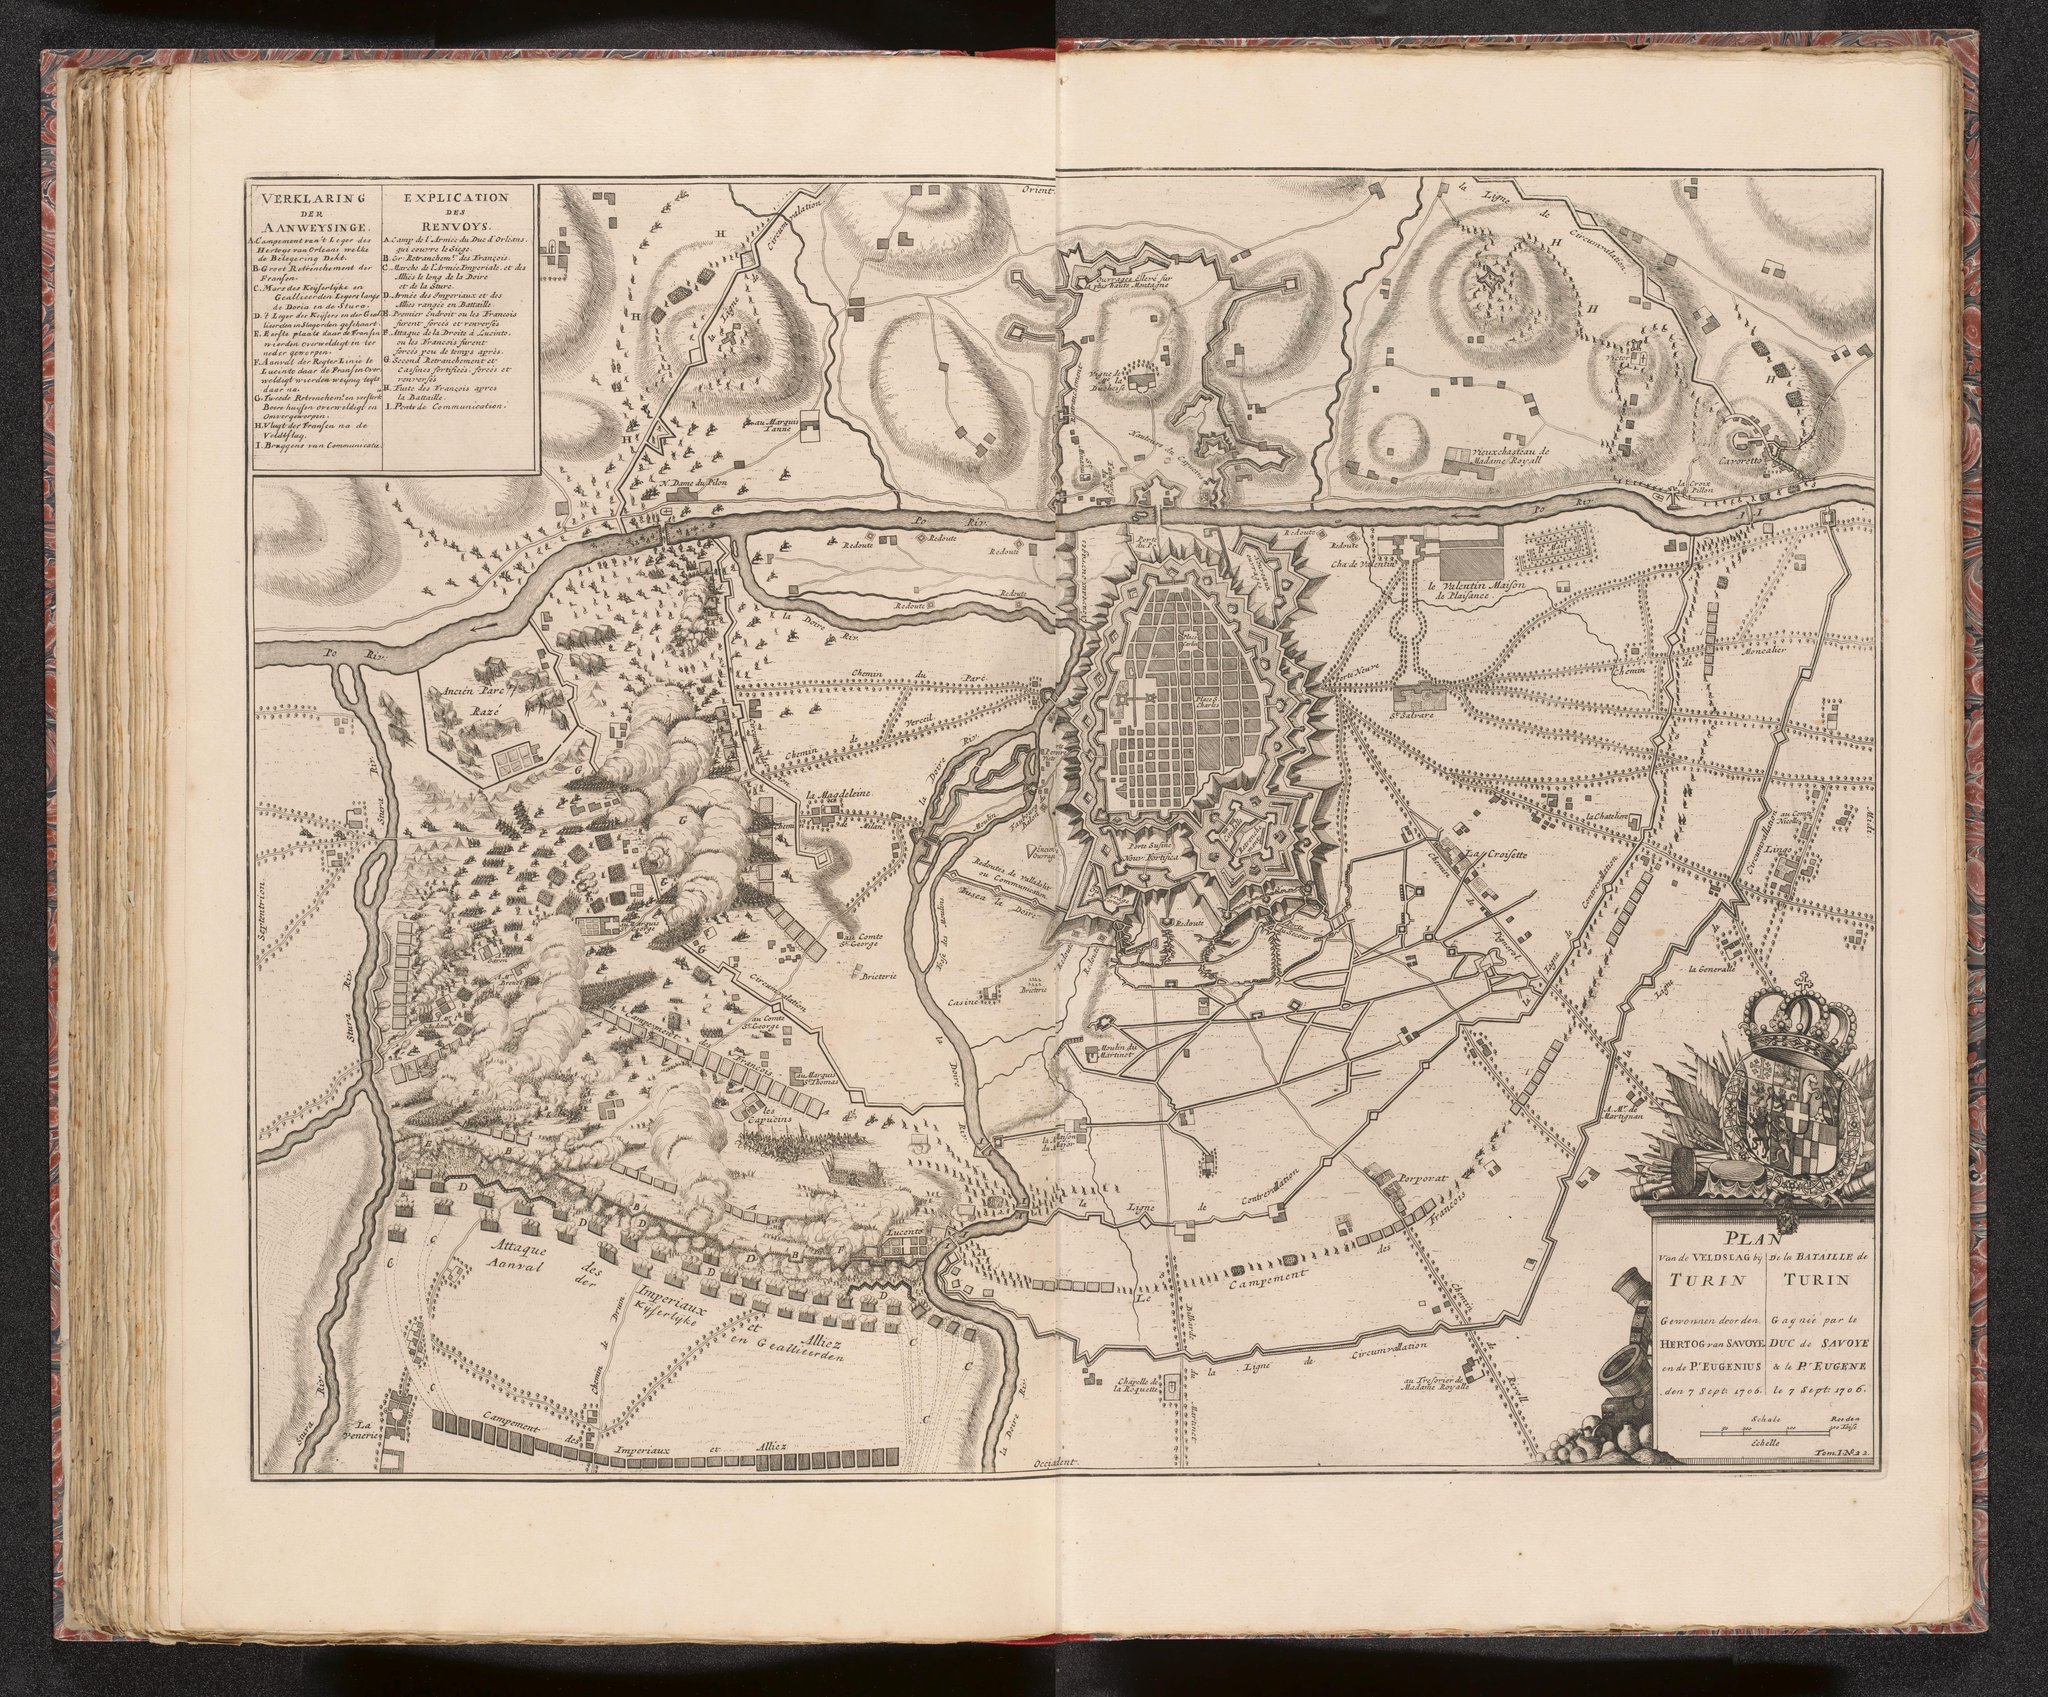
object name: map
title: Ontzet van Turijn, 1706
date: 1706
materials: paper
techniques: etching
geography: northern netherlands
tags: paris, eugenius van savoye, raising the siege with outside assistance, relief, maps of cities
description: Plattegrond van de stad Turijn door de Fransen belegerd en ontzet door de Geallieerden onder de prins van Savoye op 7 september 1706. Genummerd rechtsonder: Tom. I. No. 22. Illustratie in het eerste deel van: Jean du Mont, Oorlogskundige beschryving van de veldslagen en belegeringen, der drie ... wydvermaarde krygsoversten... den Prins Eugenius van Savoye, den ... Hertog van Marlborough, en den Prins van Oranje en Nassau-Vriesland, in de editie van 1729. Dit eerste deel is gewijd aan de daden van Eugenius, prins van Savoye.